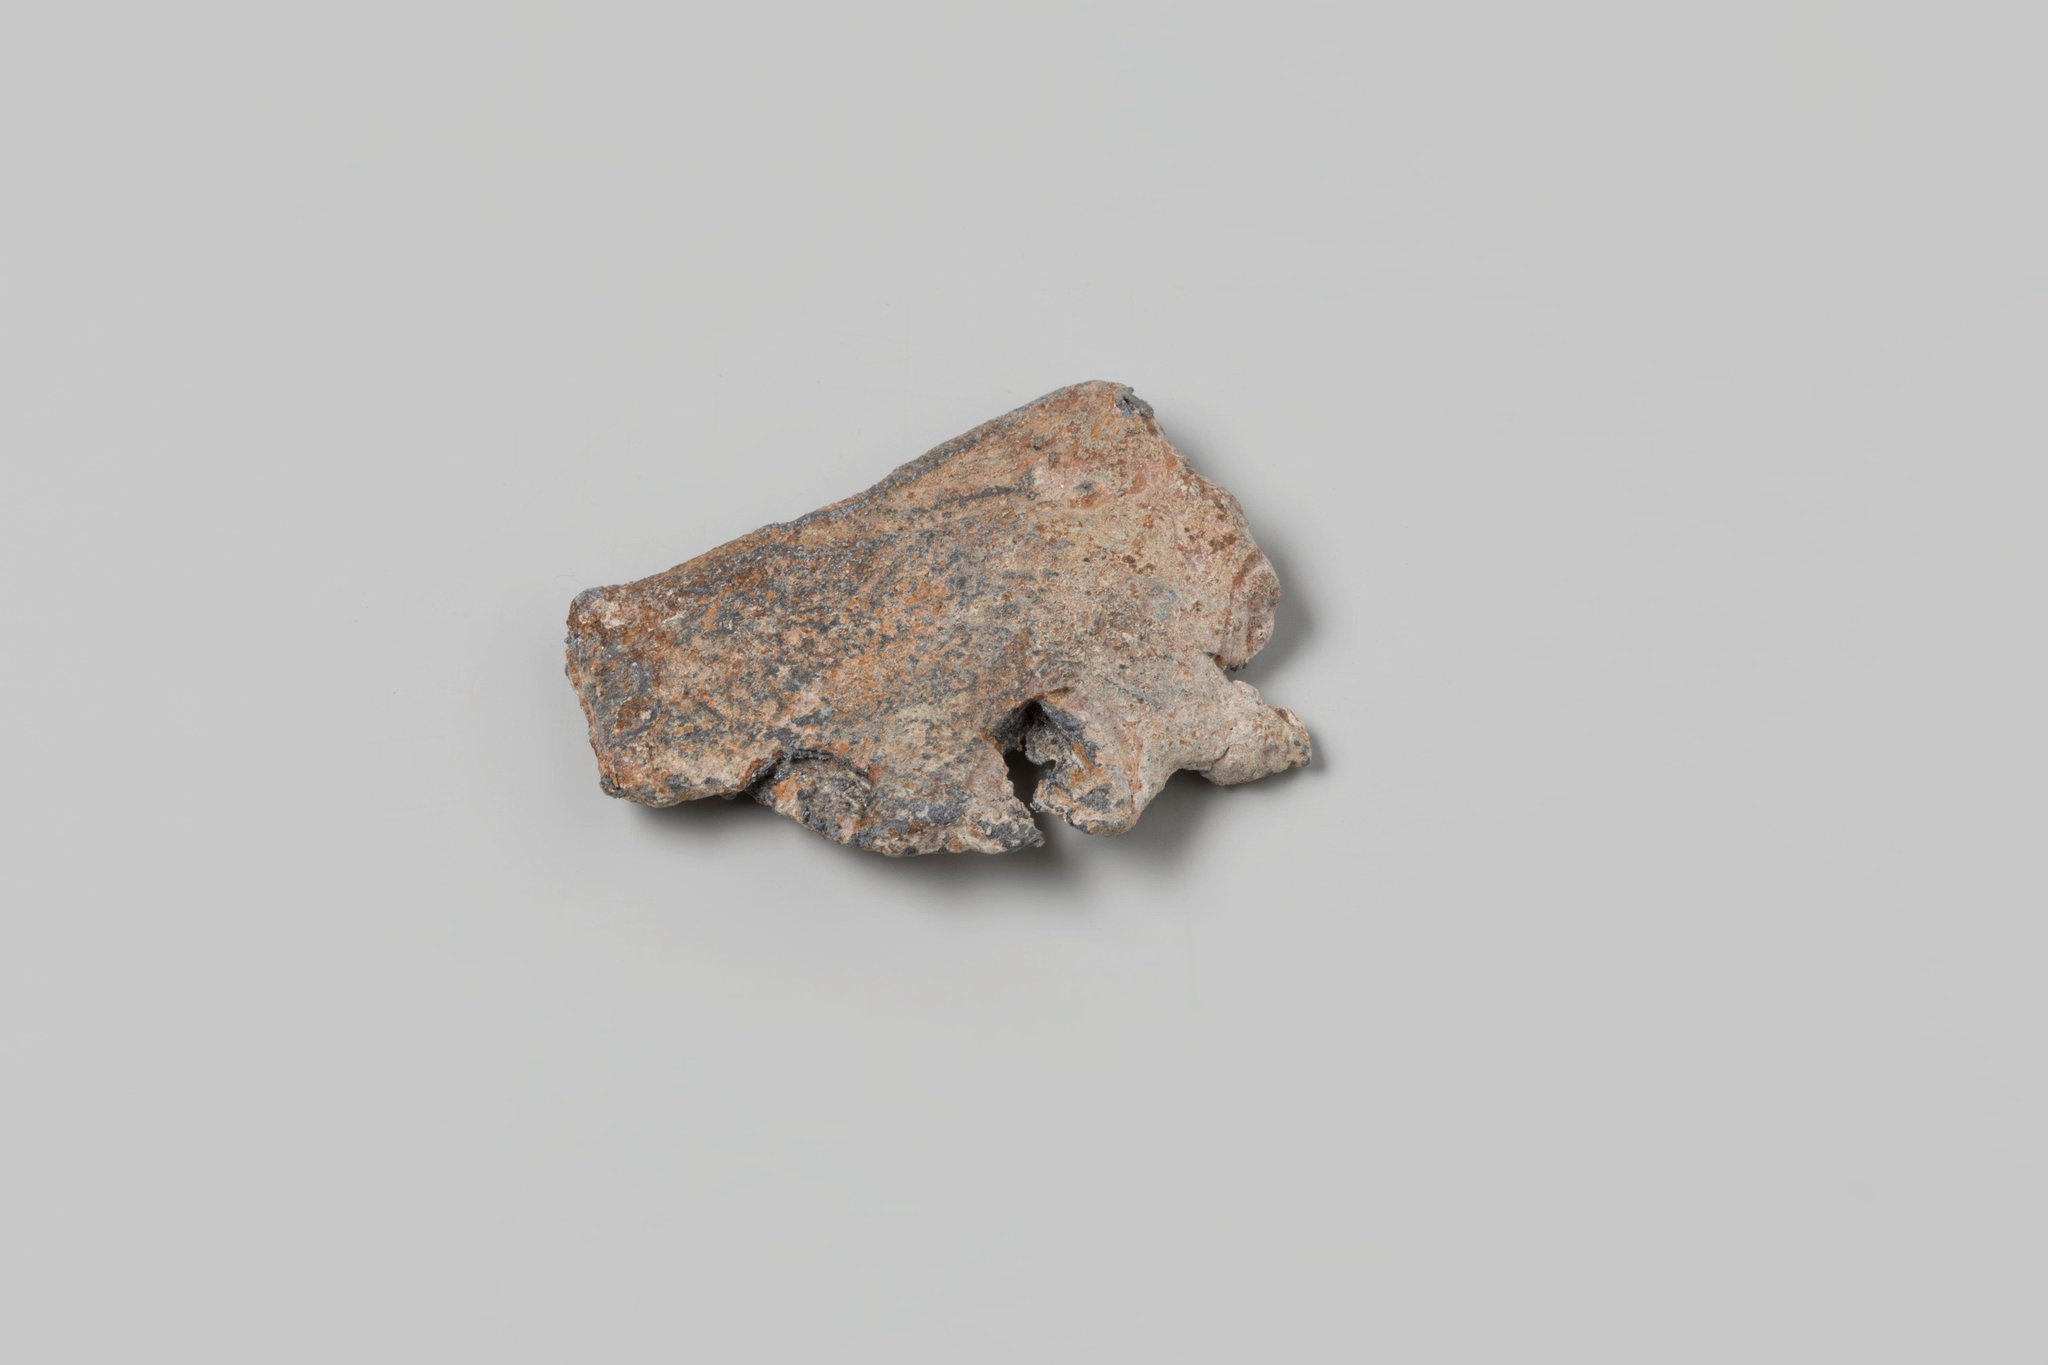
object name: fragment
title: Fragment lood uit het wrak van de Oost-Indiëvaarder Hollandia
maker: Anonymous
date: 1700-1743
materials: lead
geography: netherlands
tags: verenigde oostindische compagnie, hollandia (schip), annet